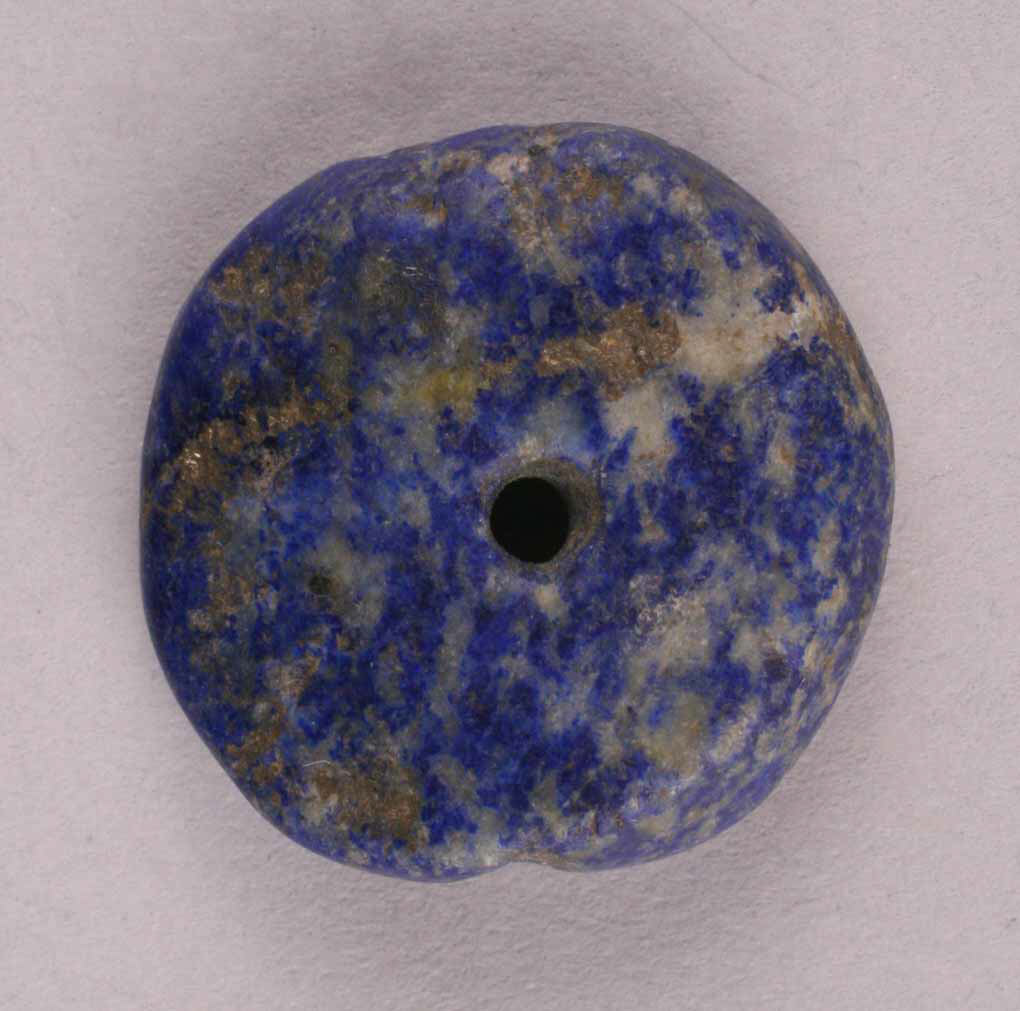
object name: bead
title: Beads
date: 801-1200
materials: lapis lazuli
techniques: cutting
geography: iran